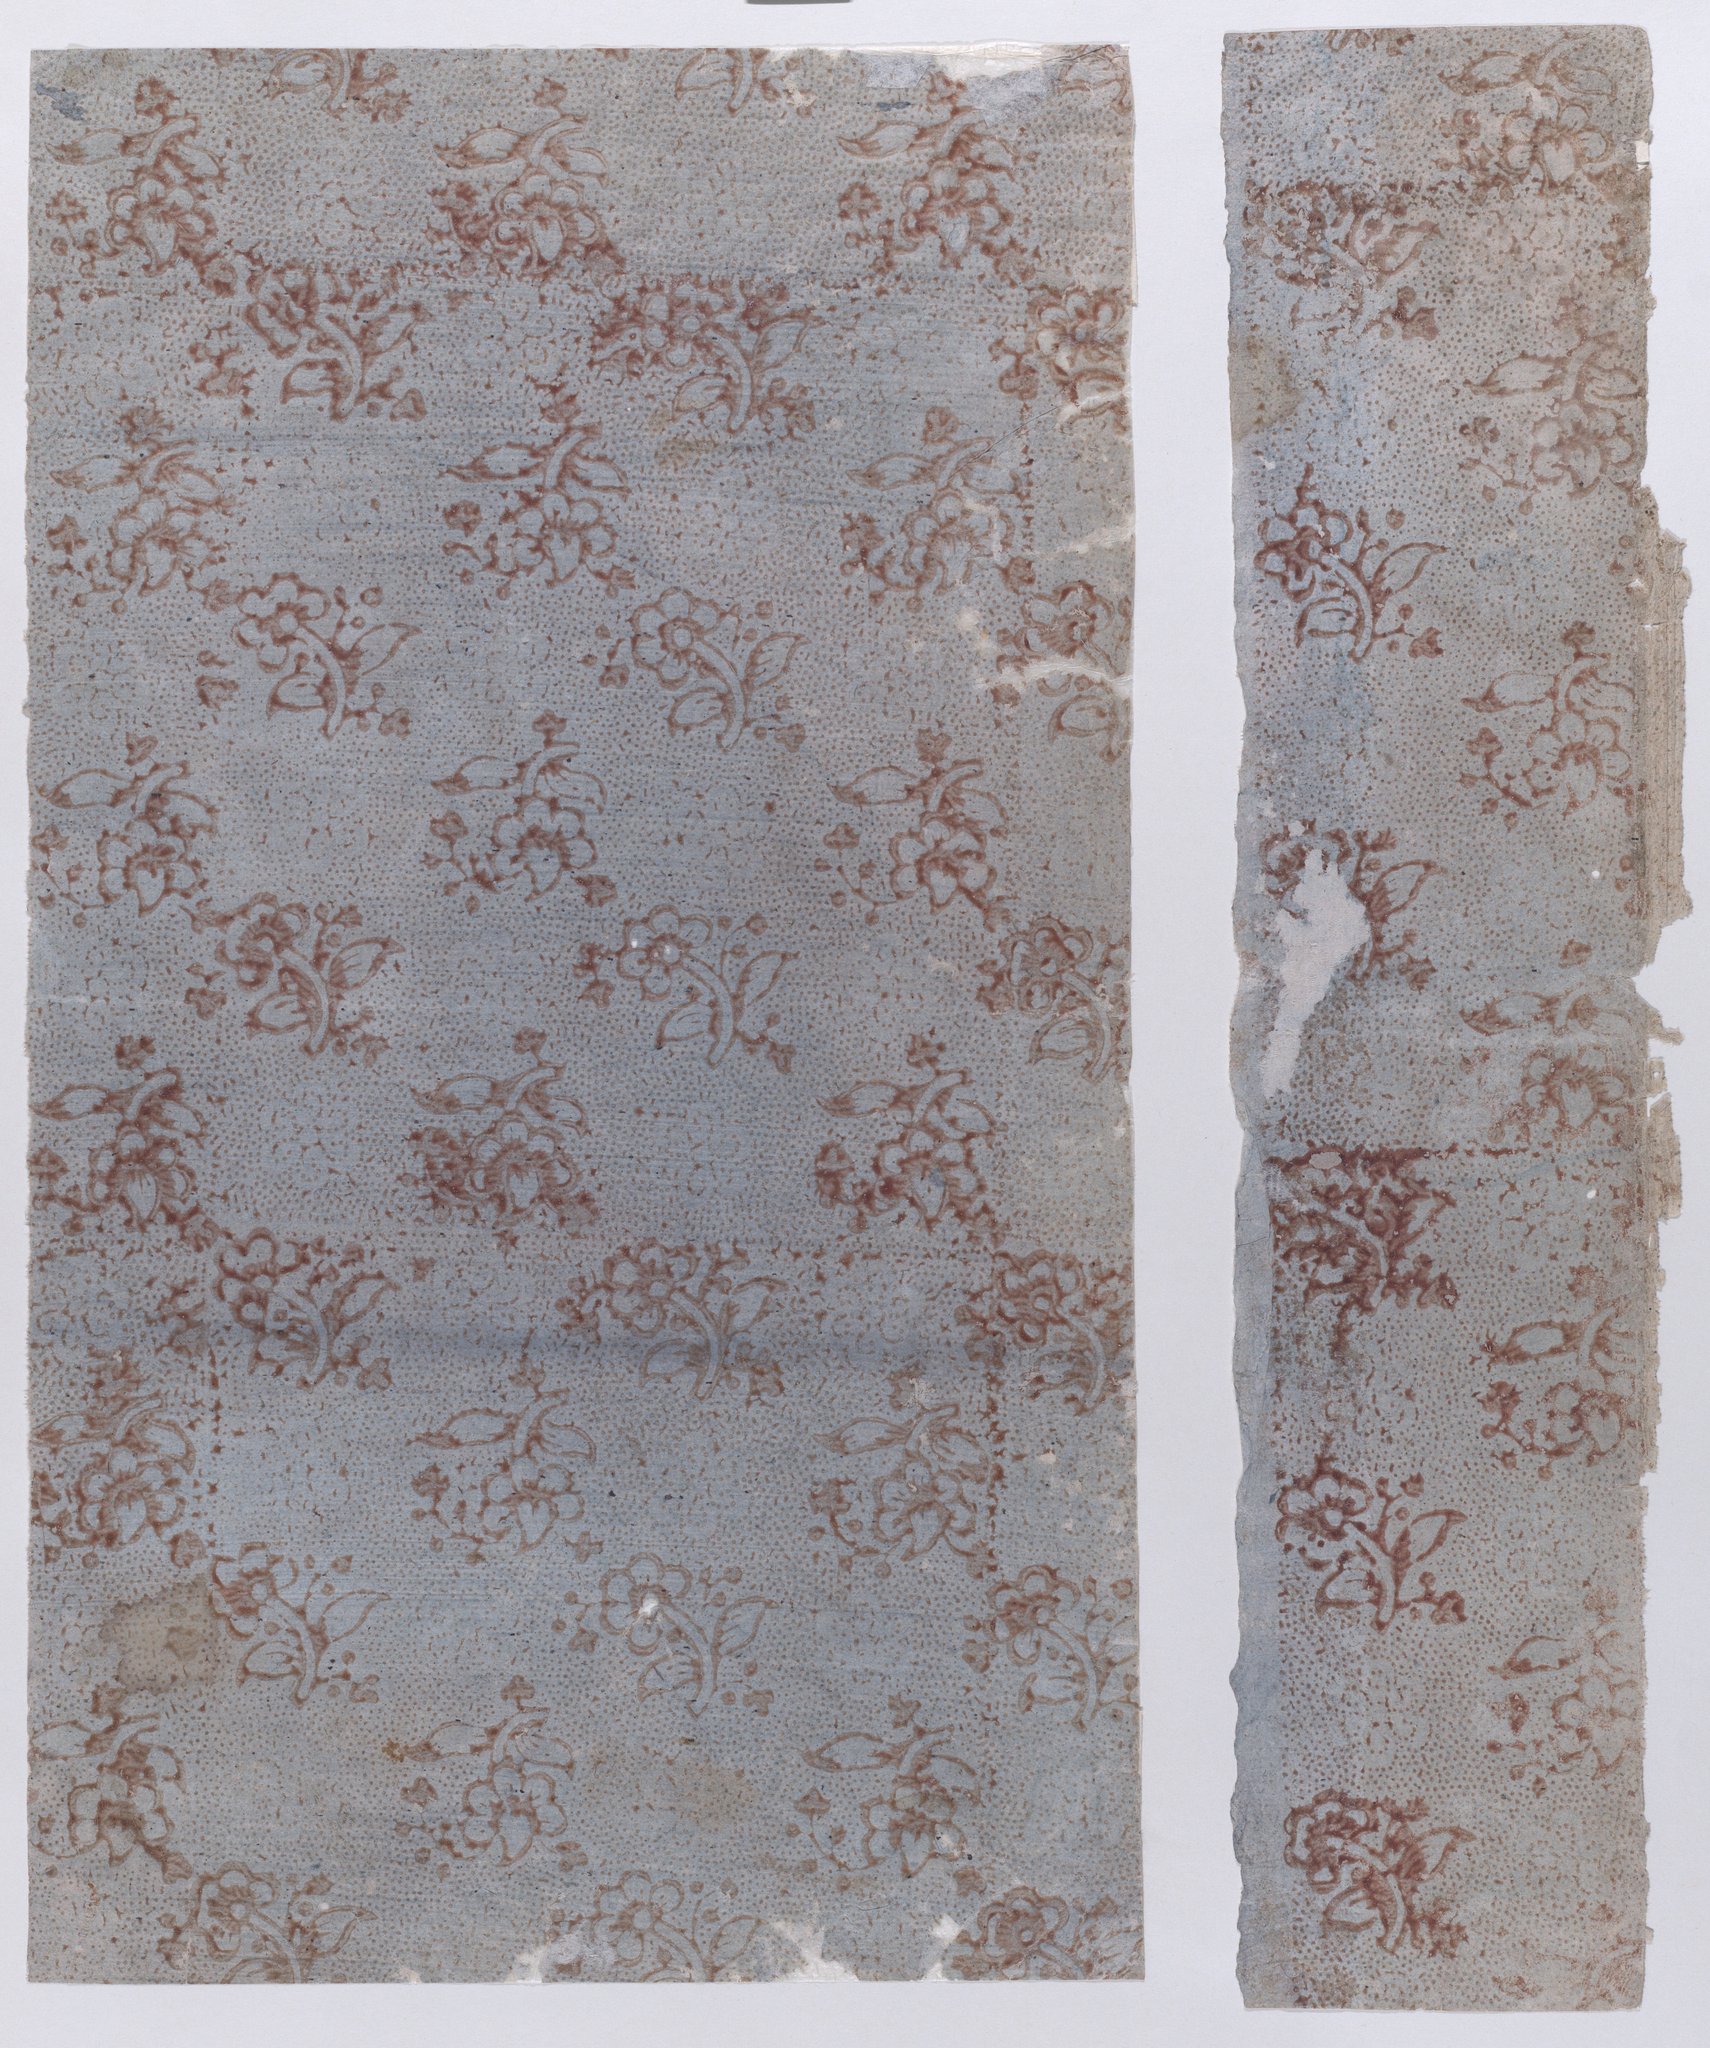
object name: print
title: Two sheets with overall floral and dot pattern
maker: Anonymous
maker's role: artist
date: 1801-1900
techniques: relief print